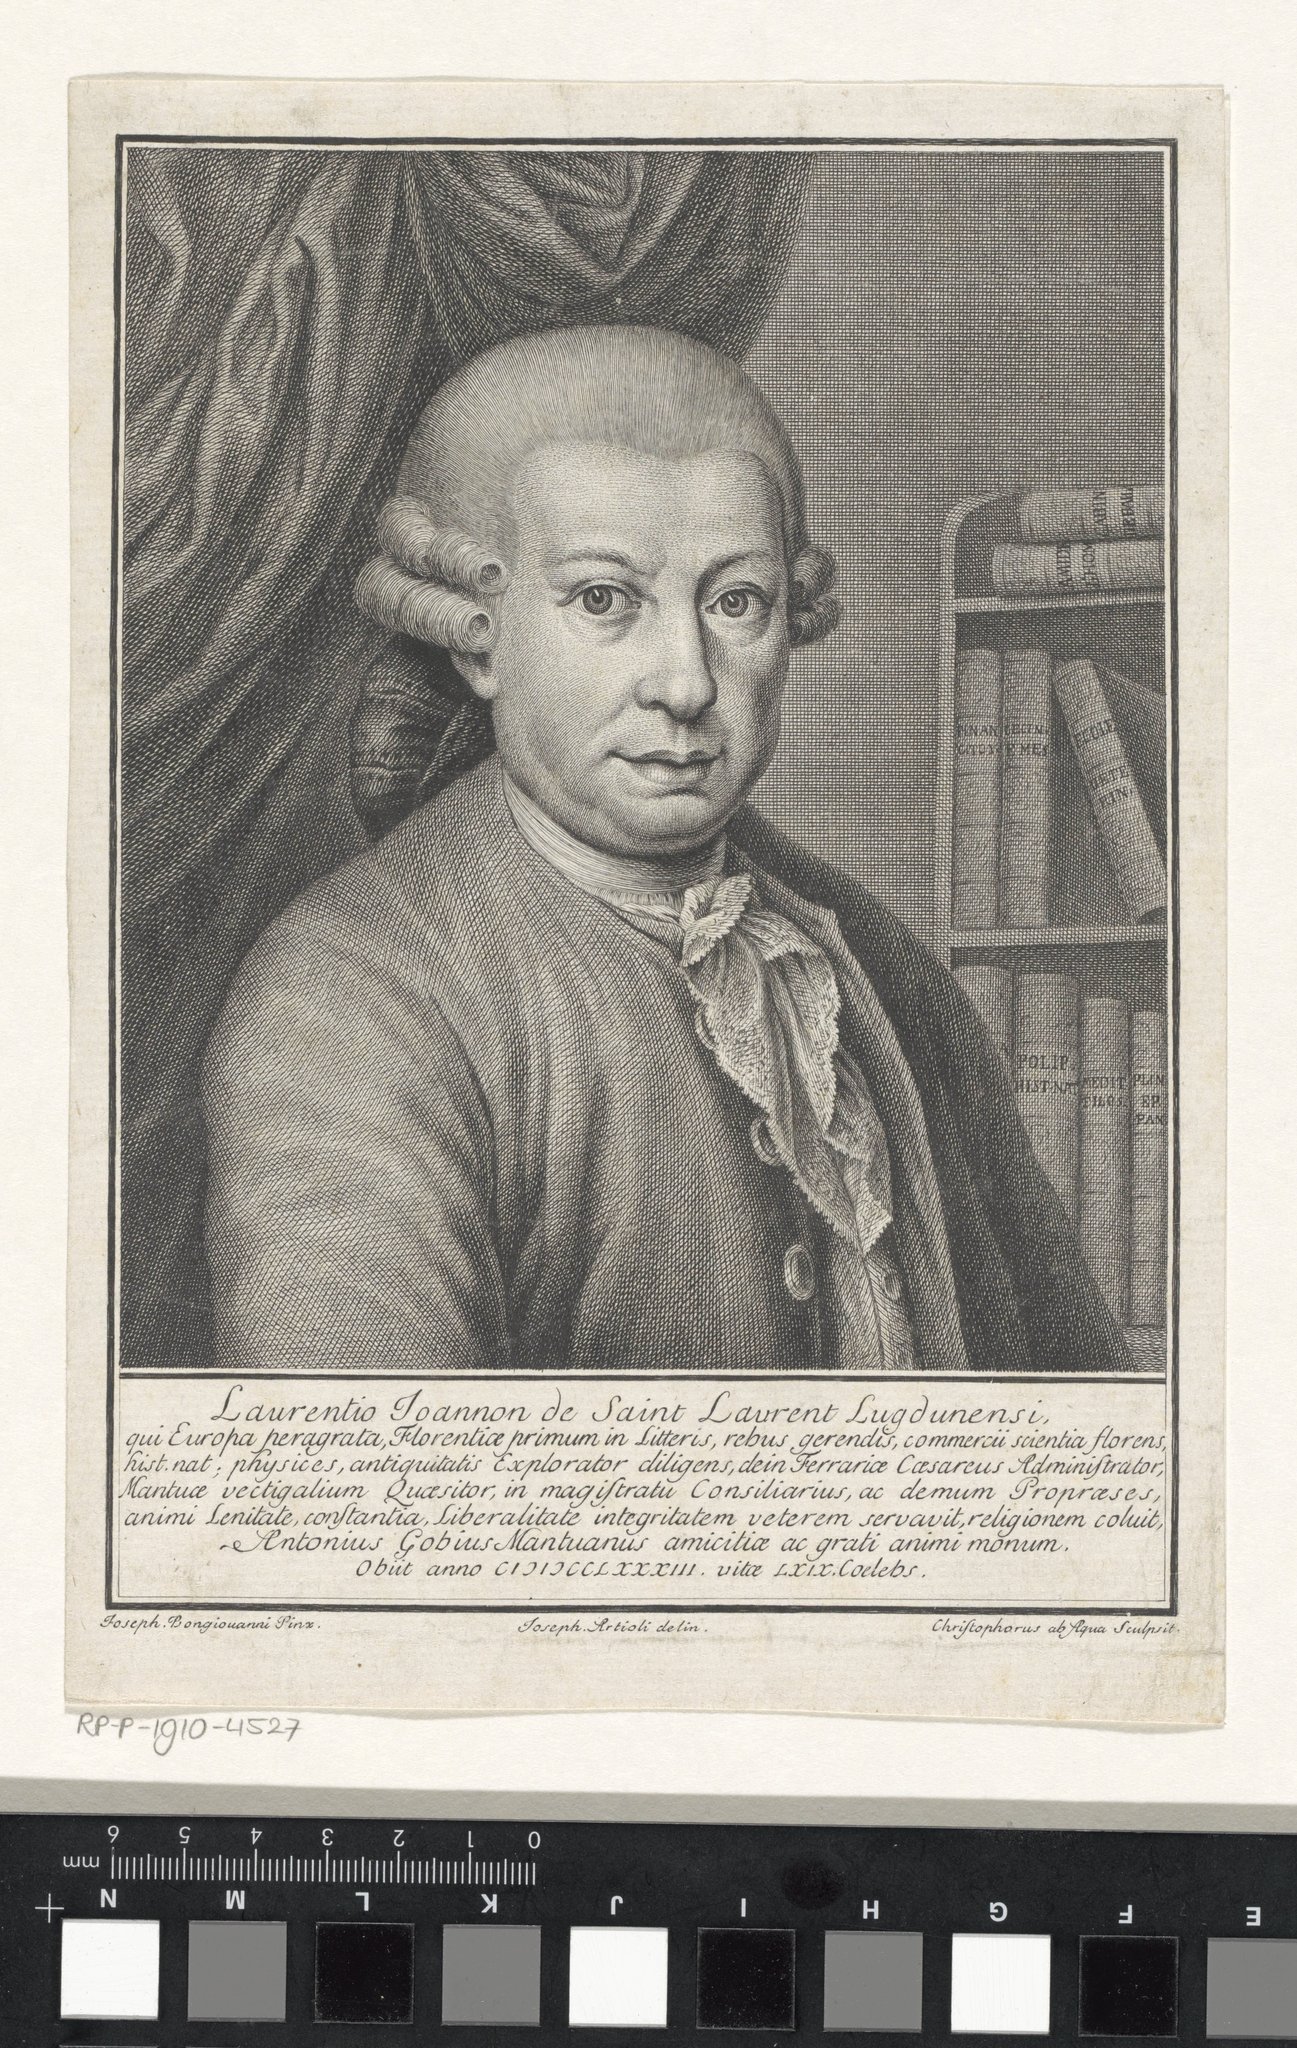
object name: print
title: Portret van Laurentio Joannon de Saint Laurent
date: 1744-1787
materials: paper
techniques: engraving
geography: italy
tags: historical persons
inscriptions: collector's mark: Lugt 2228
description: Portret van wetenschapper Laurentio Joannon de Saint Laurent uit Lyon, zittend voor een draperie en een boekenkast. In een kader zeven regels tekst in het Latijn.